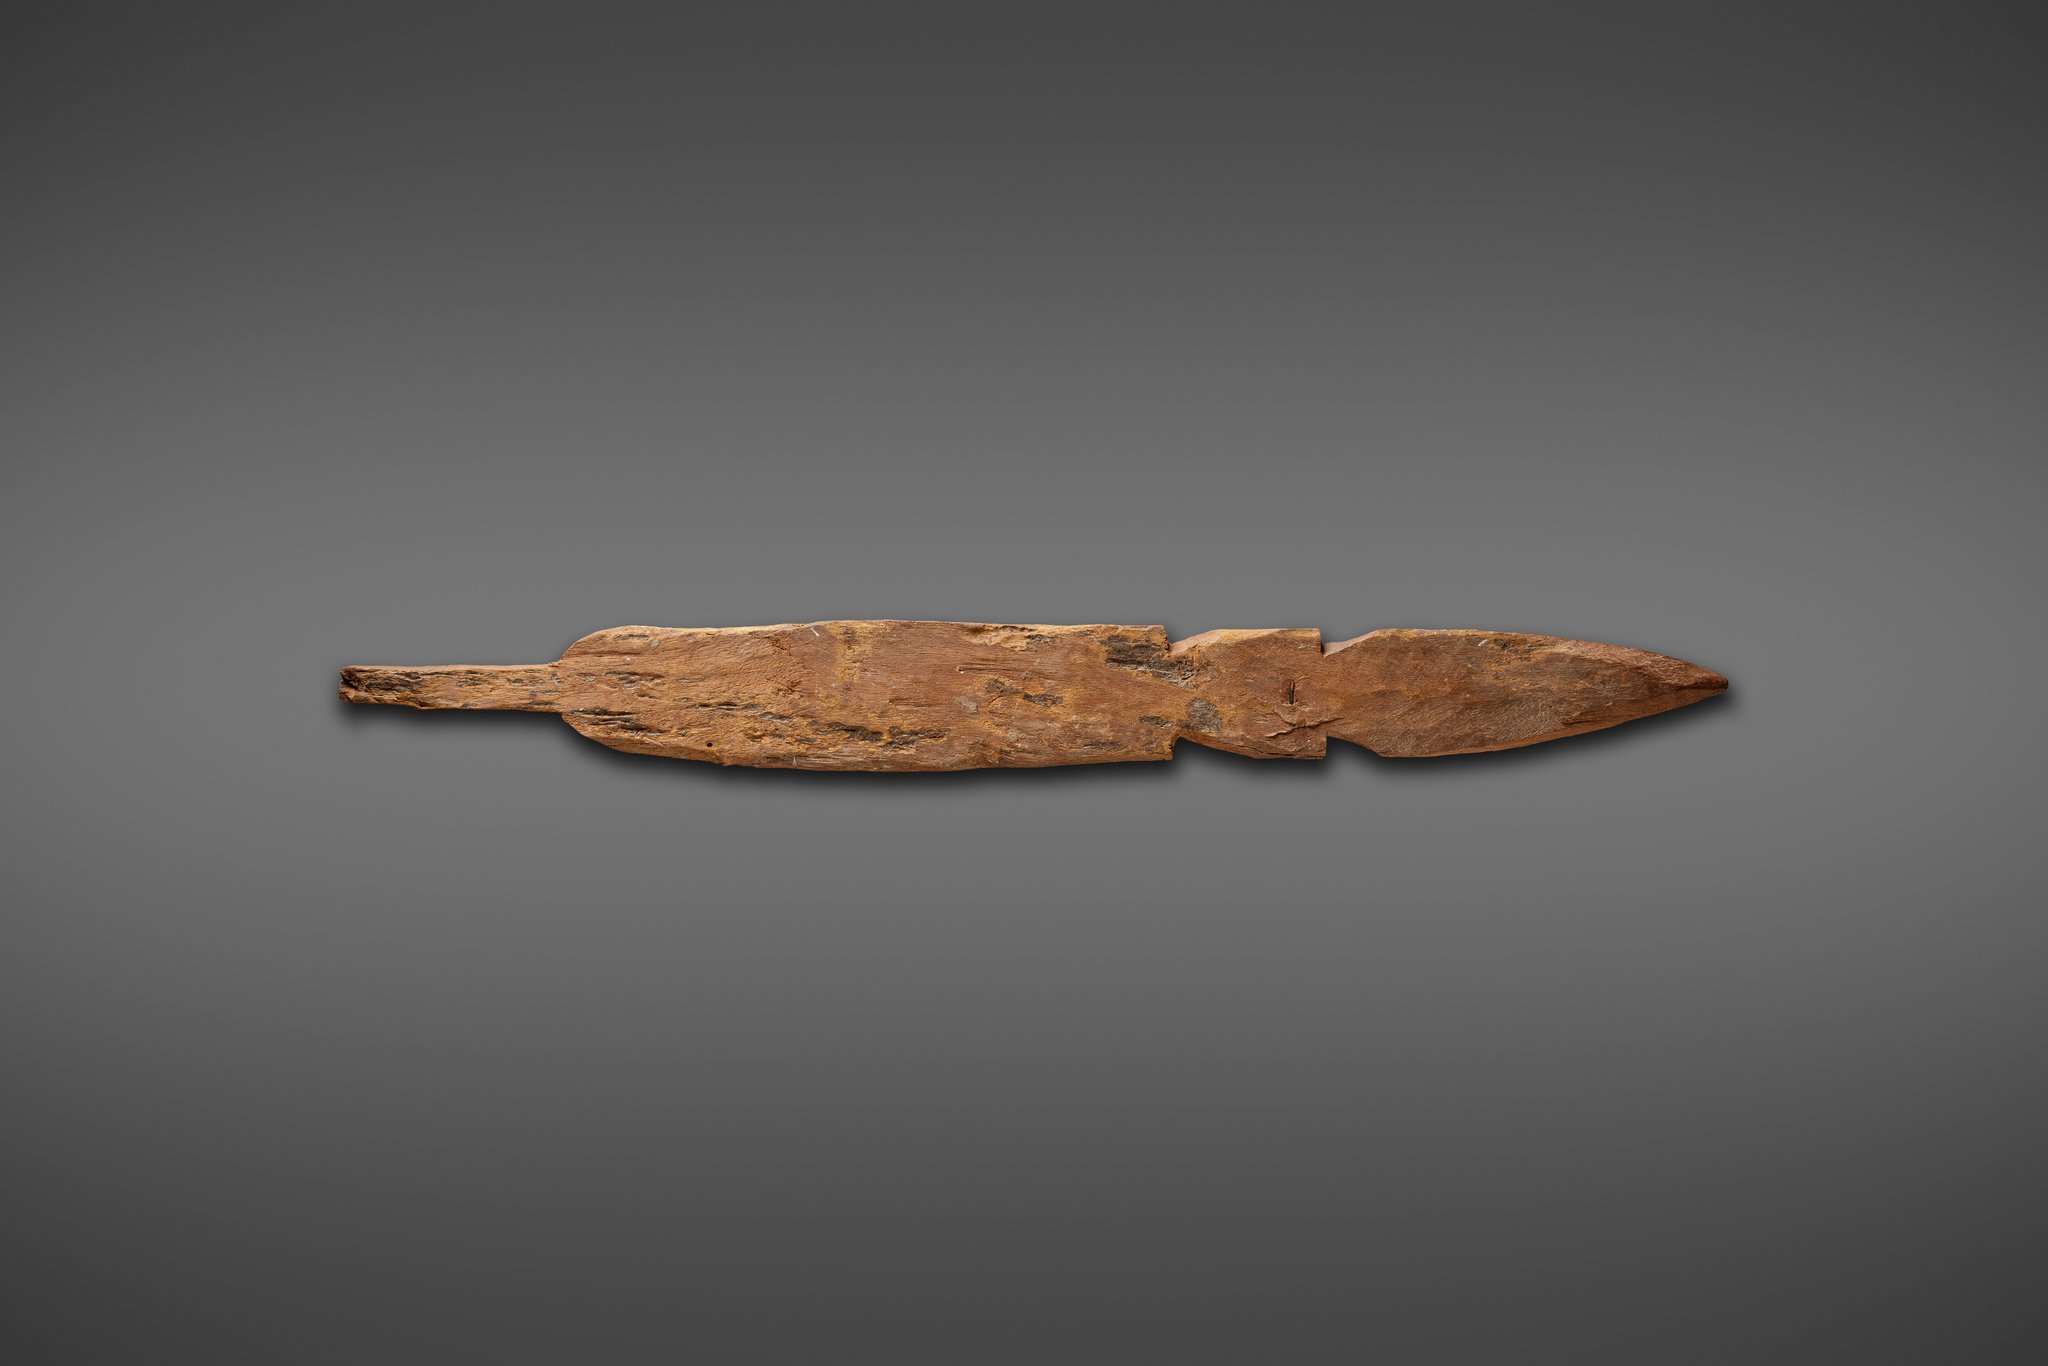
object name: pick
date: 1070-950 BCE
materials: wood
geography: egypt